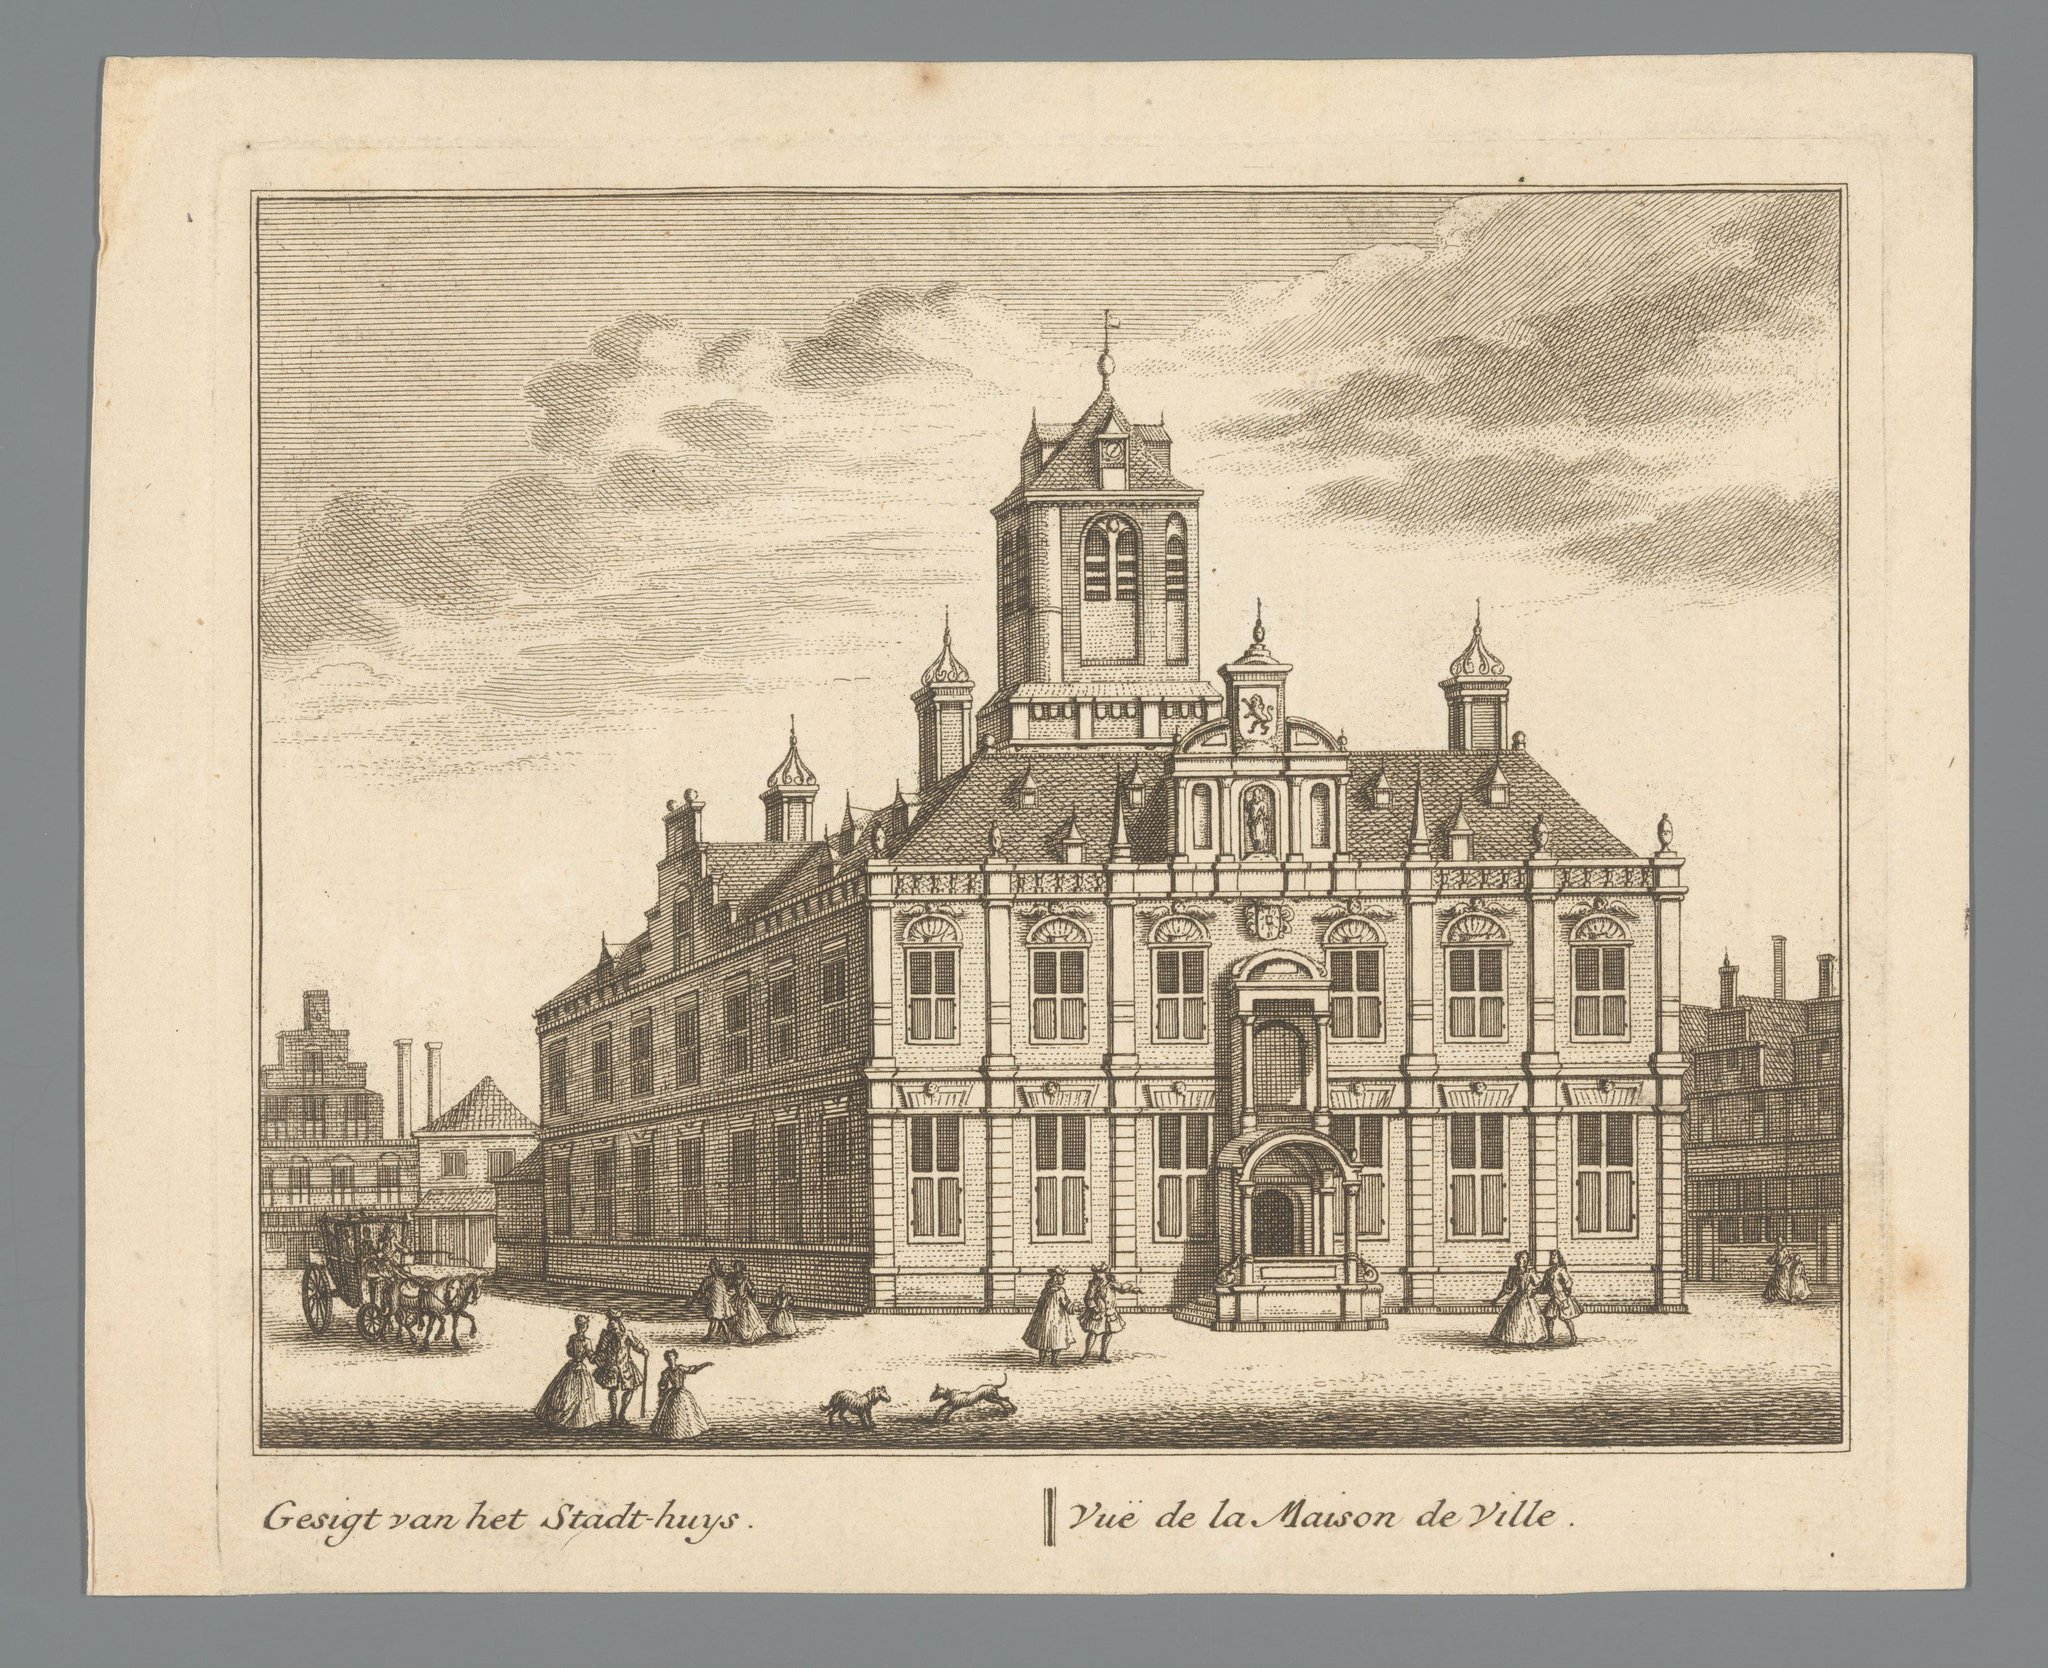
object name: print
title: Gezicht op het stadhuis te Delft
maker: leonard schenk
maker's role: print maker, publisher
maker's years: 1696-1767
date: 1736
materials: paper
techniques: etching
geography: amsterdam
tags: townhall, square, place, circus, etc. (+ city(-scape) with figures, staffage)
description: Prent uit: Rademaker, Abraham, en Leonard Schenk. Alle de voornaamste gesigten van de Wydberoemde Steeden Alkmaar, Delft en Dordregt (...). Amsterdam: Leonard Schenk, 1736.